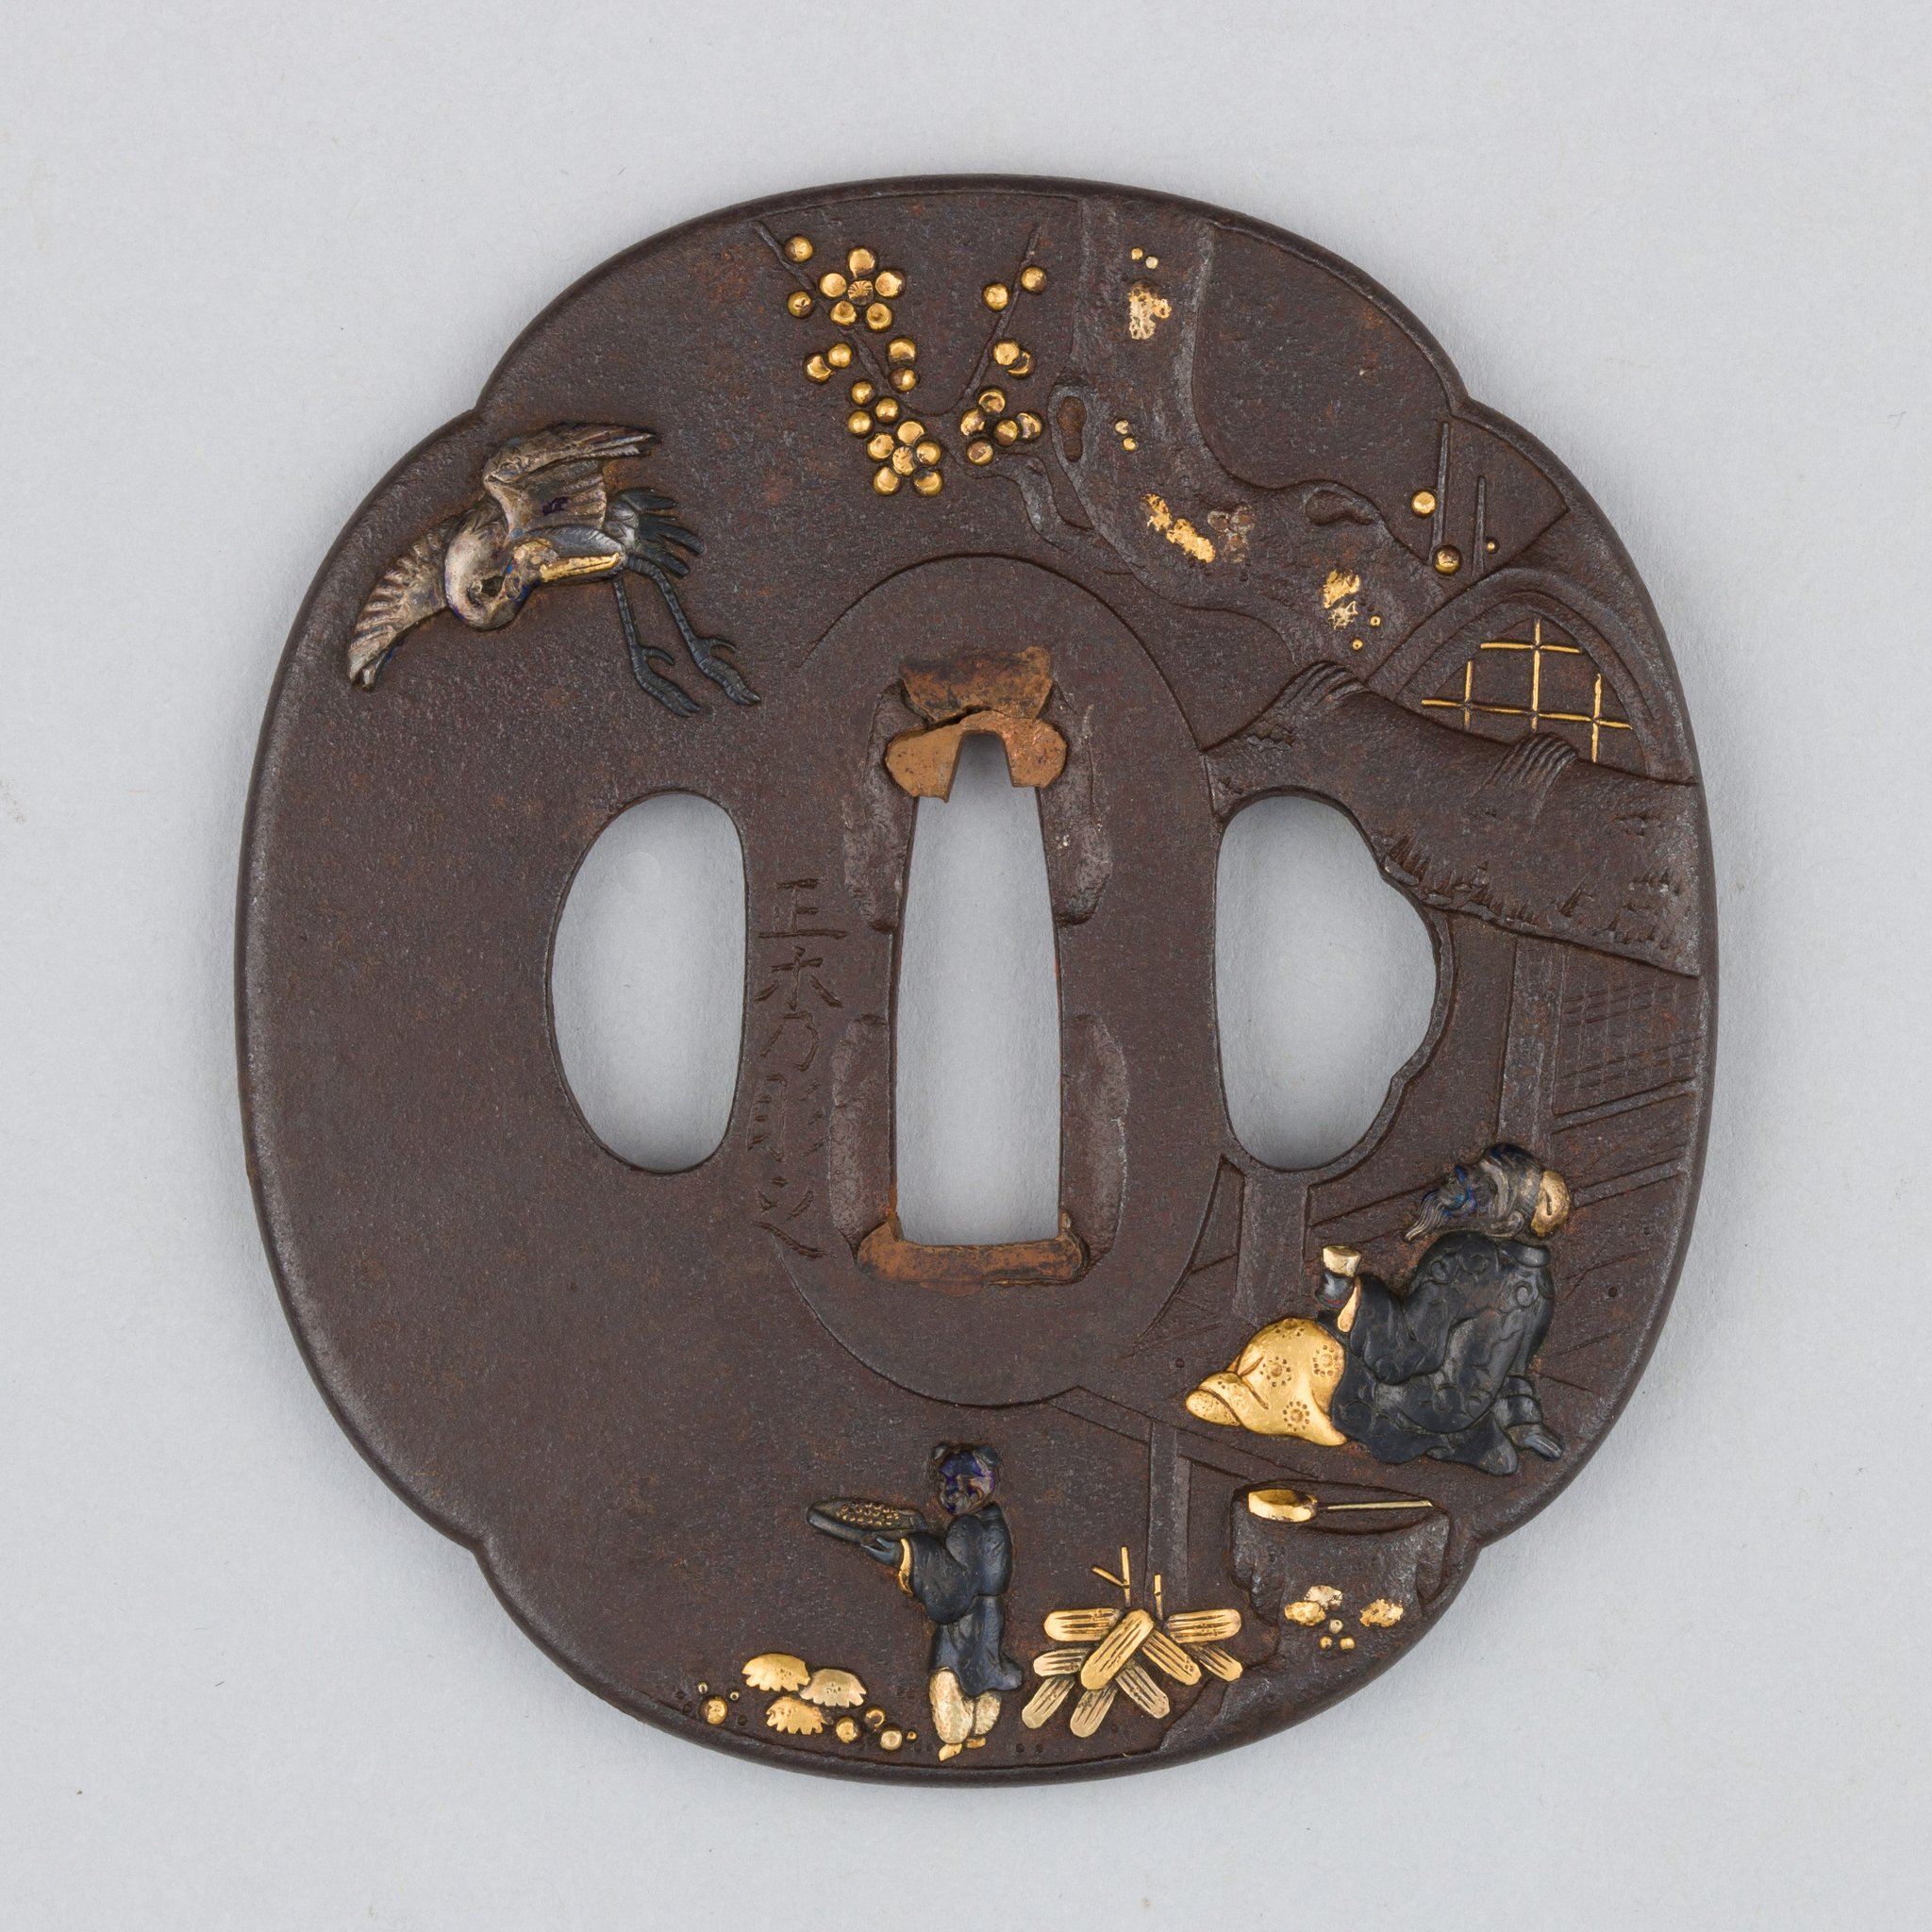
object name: sword guard tsuba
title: Sword Guard (Tsuba)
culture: japanese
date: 1800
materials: copper, gold alloy, gold, iron, silver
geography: japan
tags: birds,men